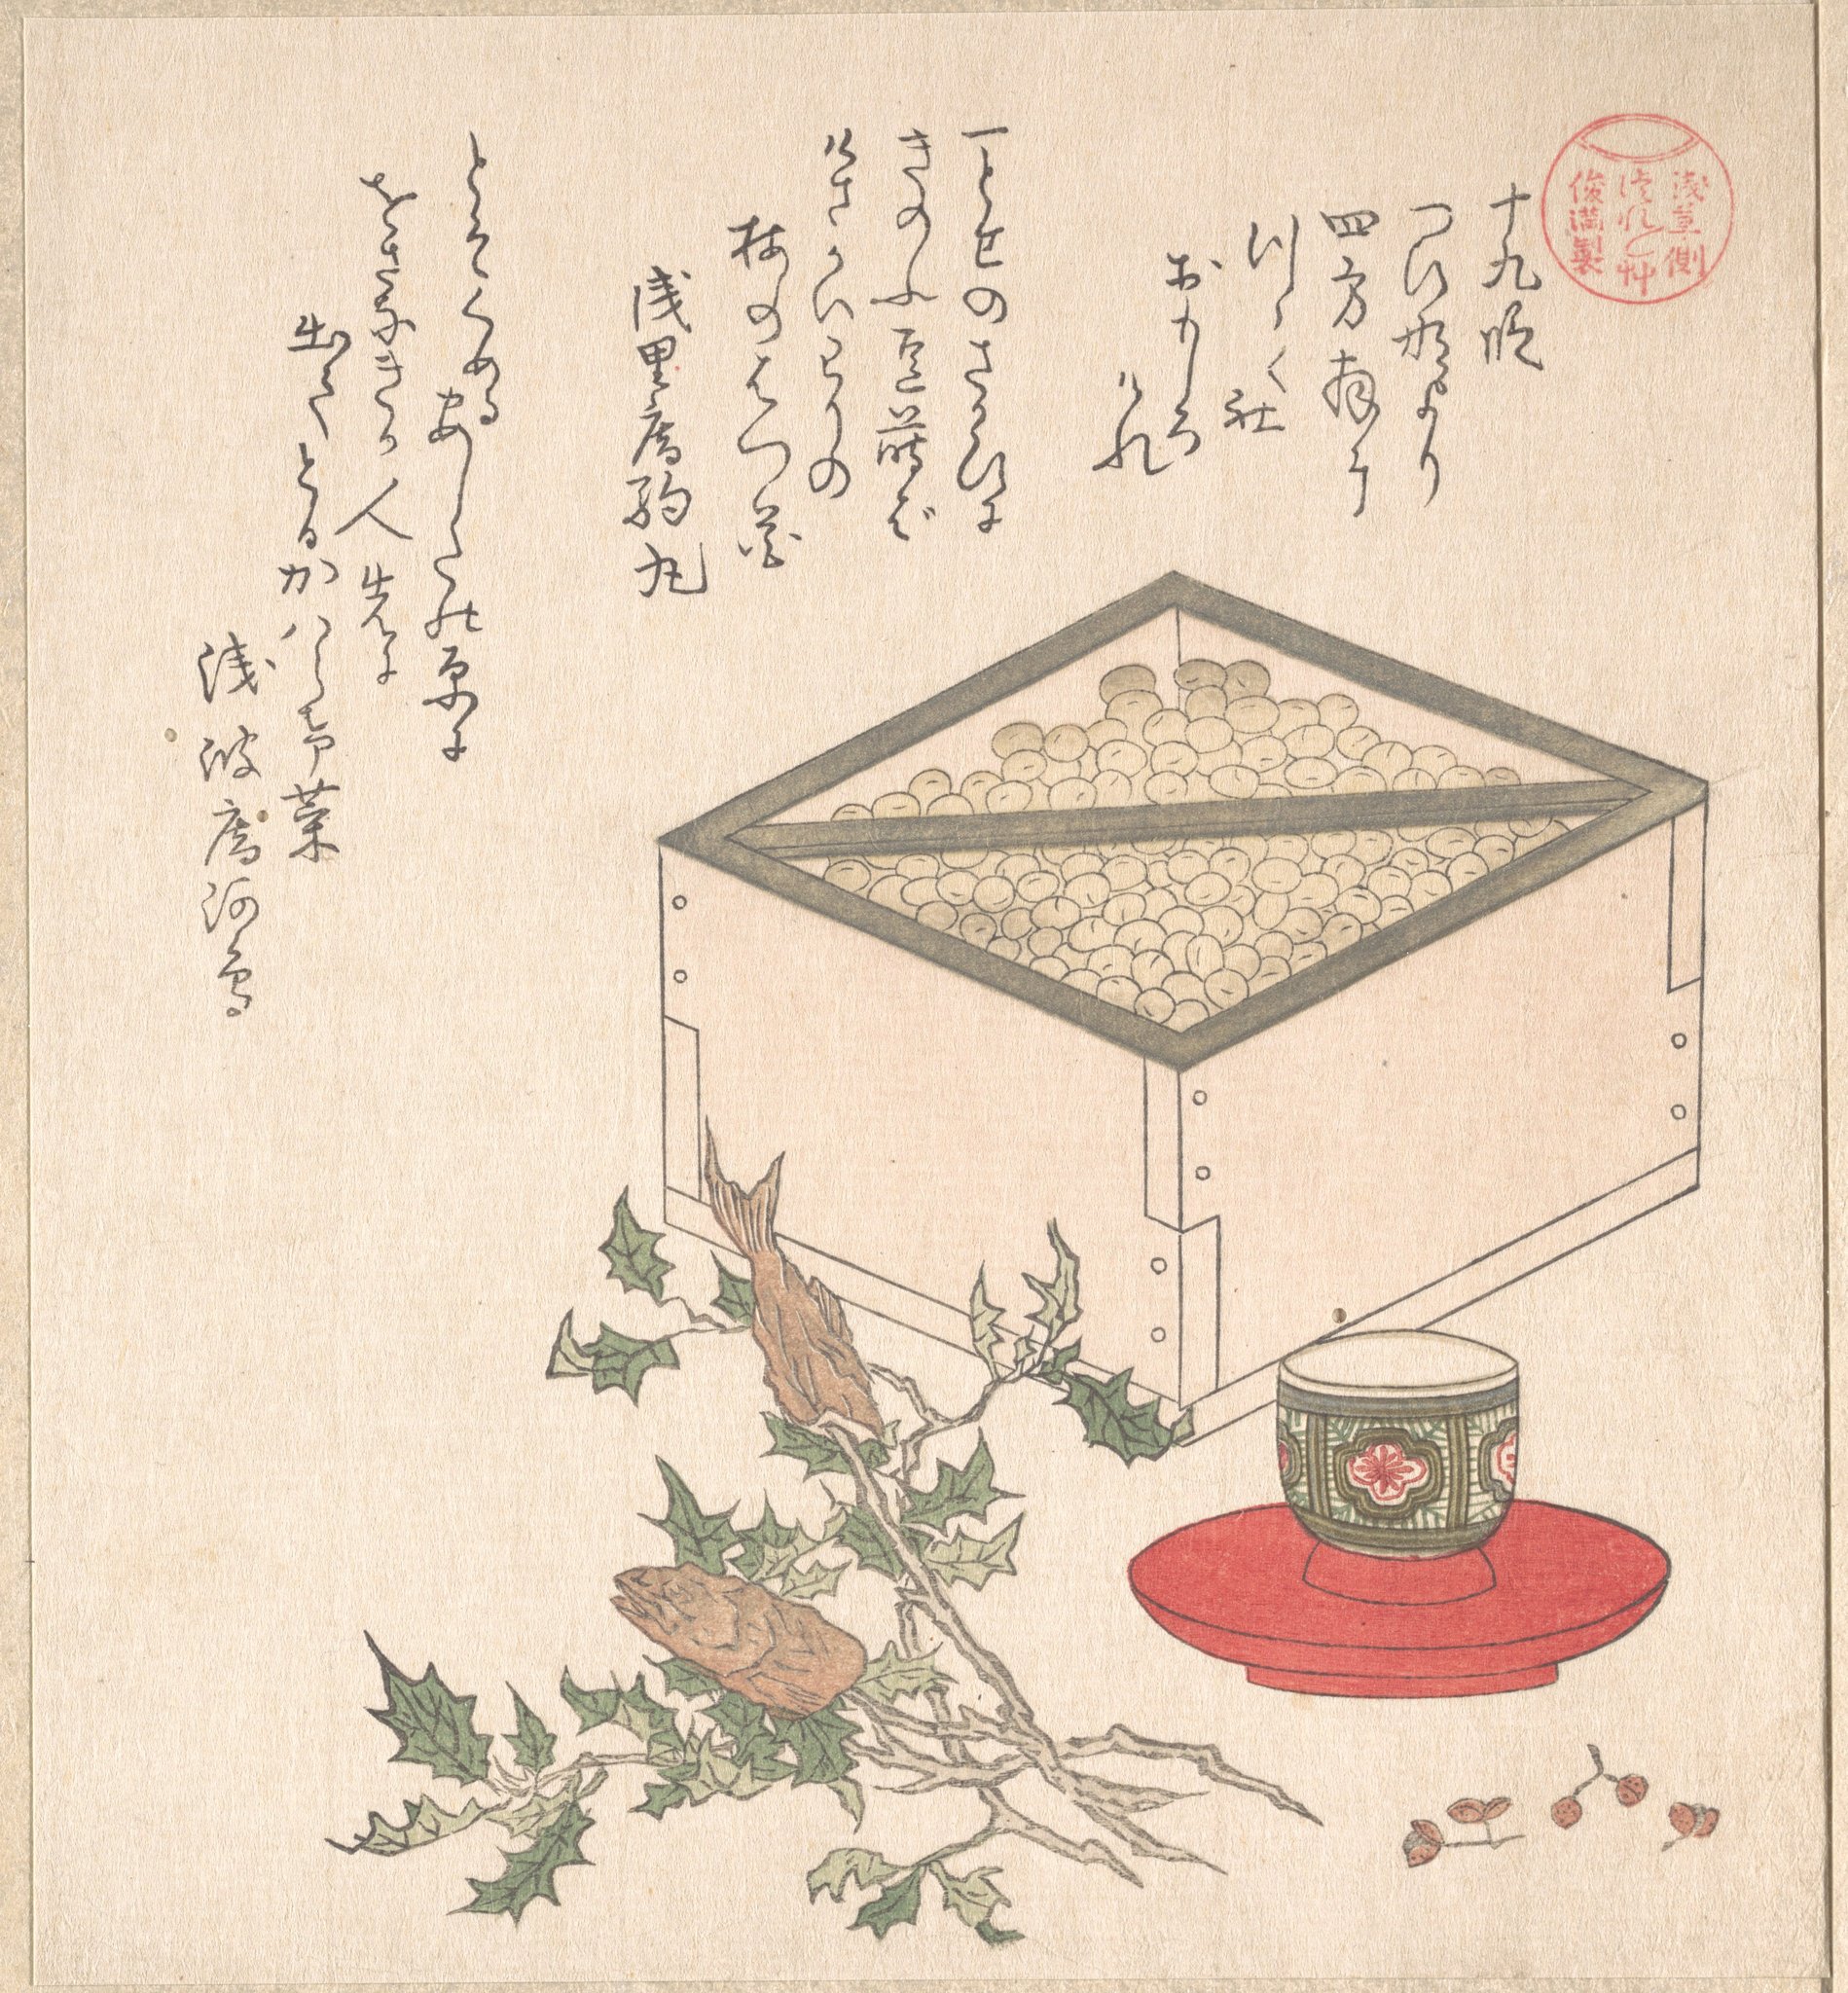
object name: woodblock print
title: Green Peas in a Measure and Sprays of Hollyhock with Heads of Sardines; Symbols Representing the Ceremony of Exorcising Demons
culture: japanese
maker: kubo shunman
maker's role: artist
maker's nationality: japanese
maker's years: 1757-1820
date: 1801-1900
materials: ink, paper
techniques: surimono, woodblock print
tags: food,vegetables,fish